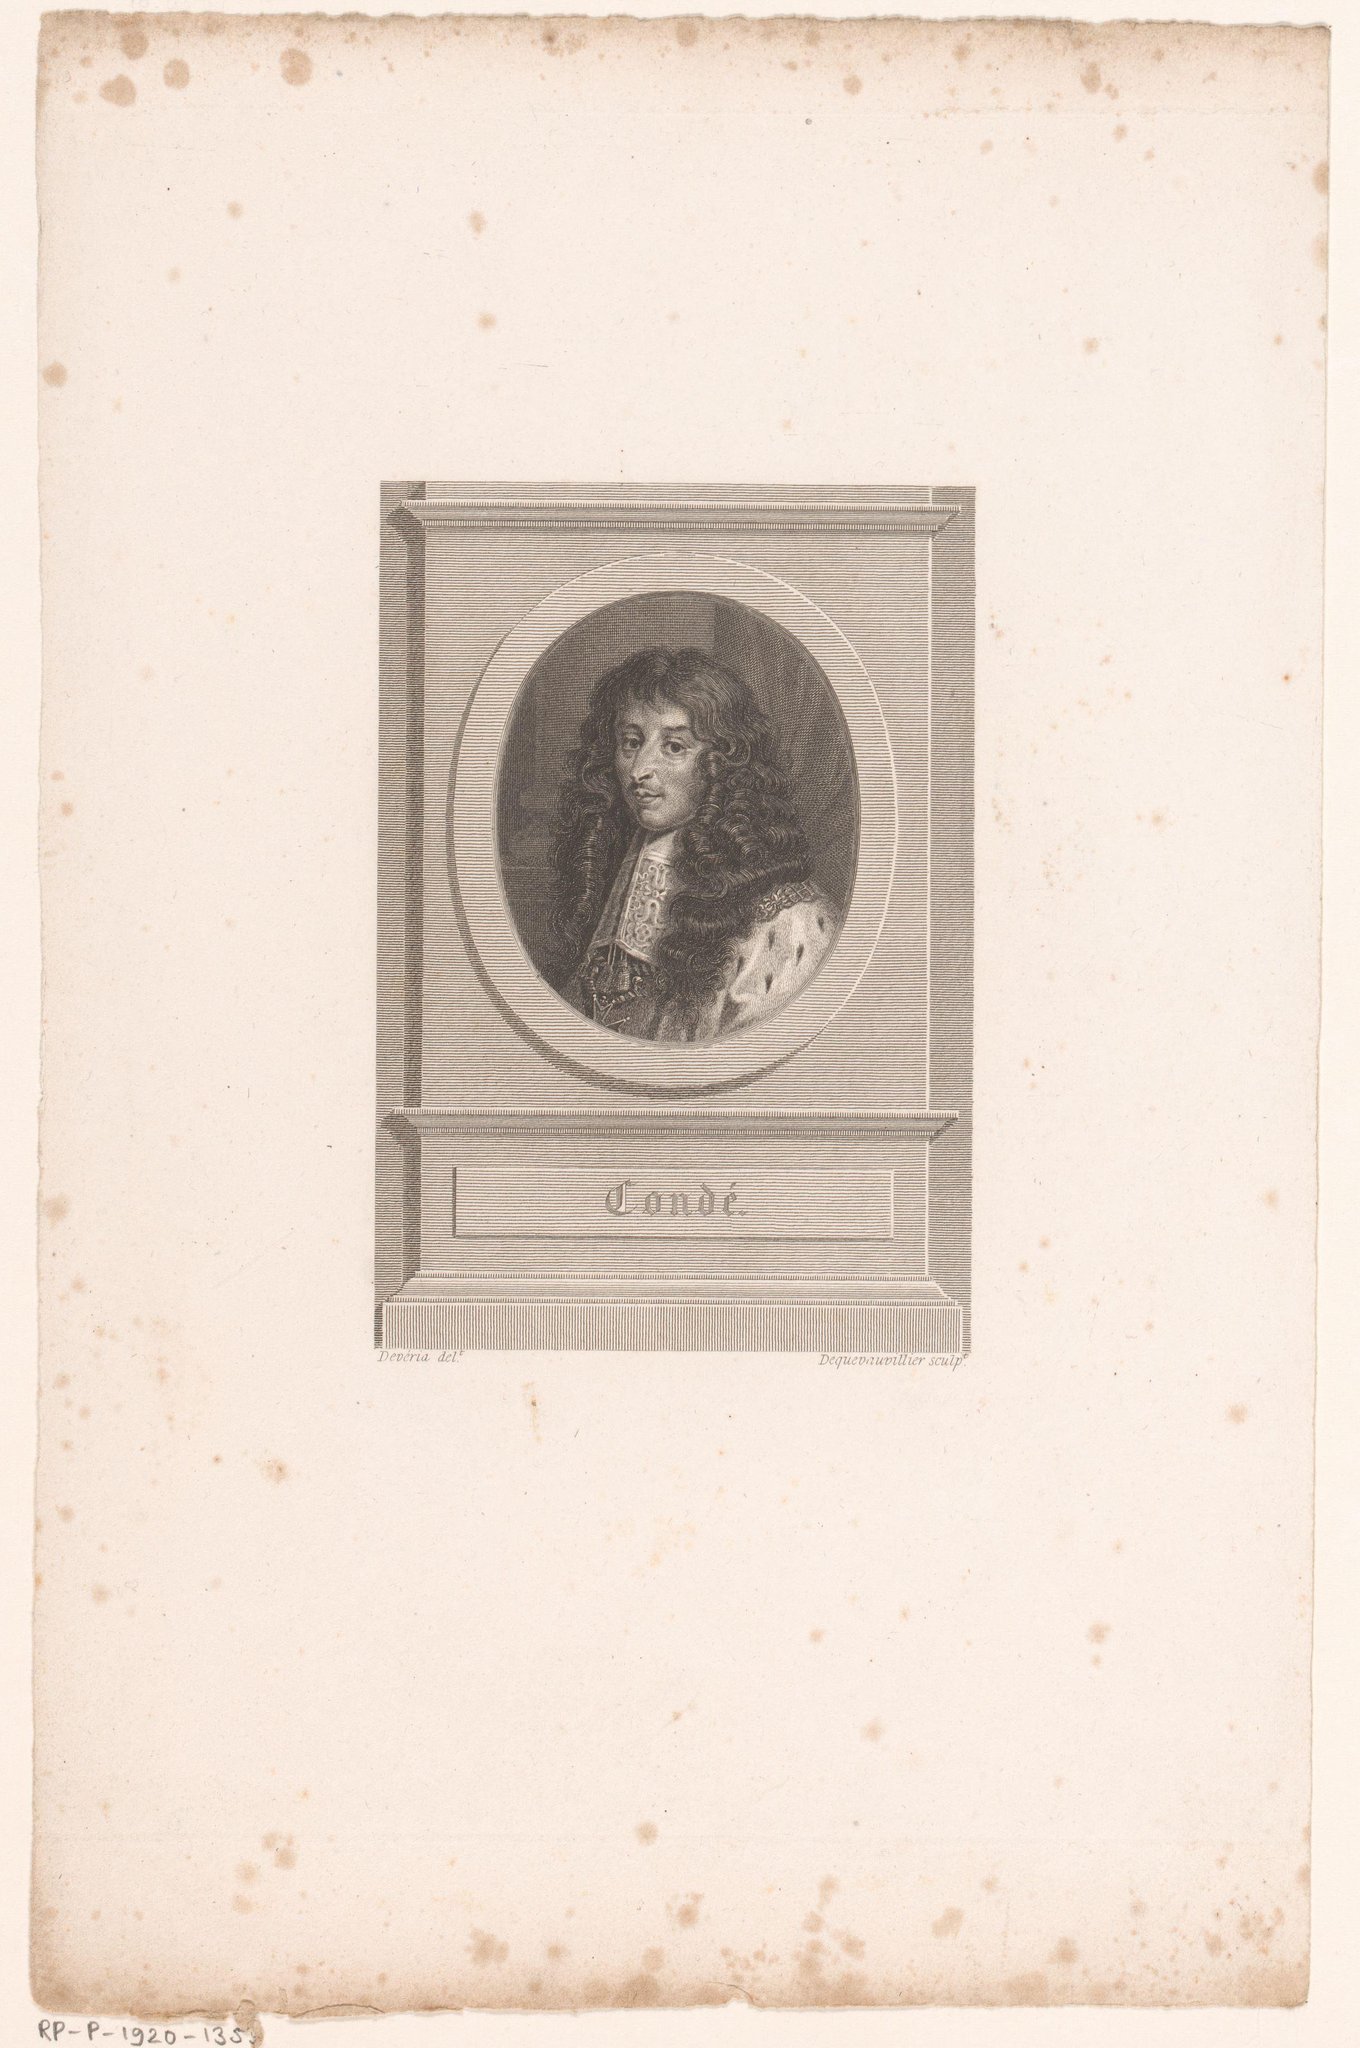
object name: print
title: Portret van Lodewijk II de Bourbon-Condé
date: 1810-1848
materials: paper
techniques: engraving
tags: paris, lodewijk ii de bourbon-condé (hertog van enghien), commander-in-chief, general, marshal, historical persons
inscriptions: collector's mark: Lugt 2228